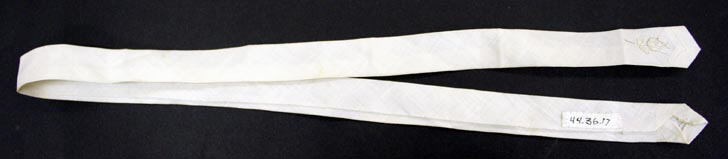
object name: necktie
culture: american or european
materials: cotton